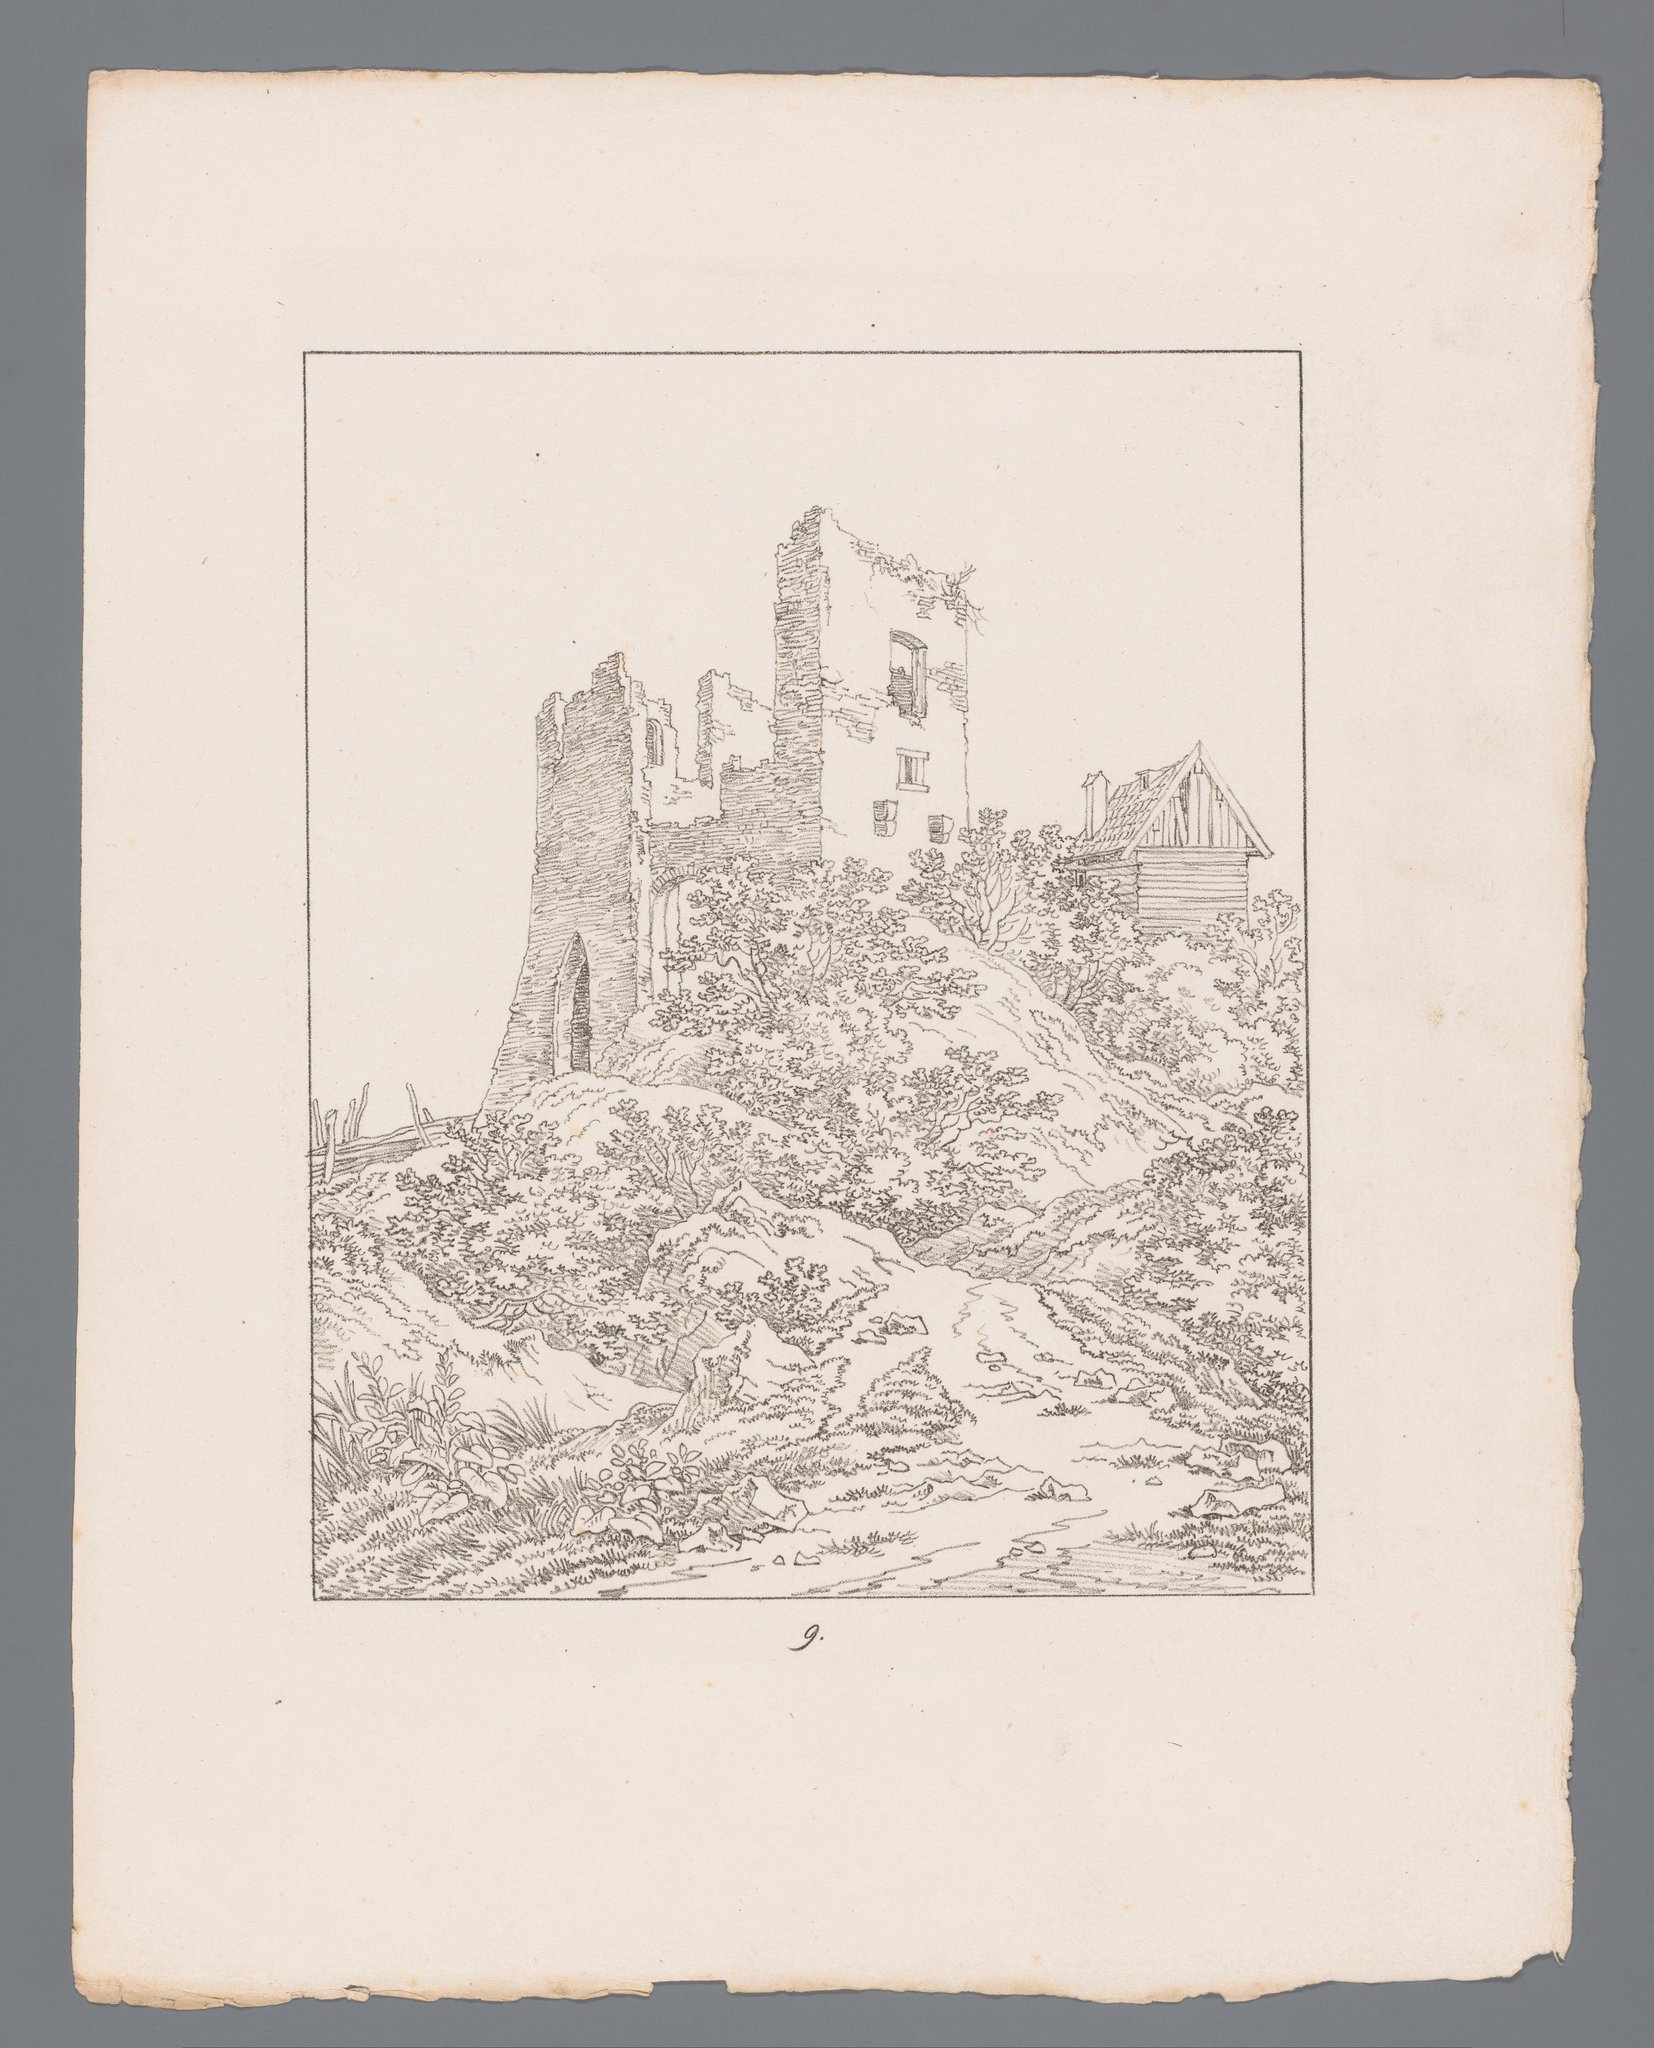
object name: print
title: Voorbeelden voor de landschapstekenaar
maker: max josef wagenbauer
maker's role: print maker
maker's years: 1774-1829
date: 1823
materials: paper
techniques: lithograph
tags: landscape with ruins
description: Onderdeel van een tweedelige serie waarvan het tweede deel bestaat uit een titelprent en twaalf voorstellingen van takken, bladeren, bomen en landschappen.